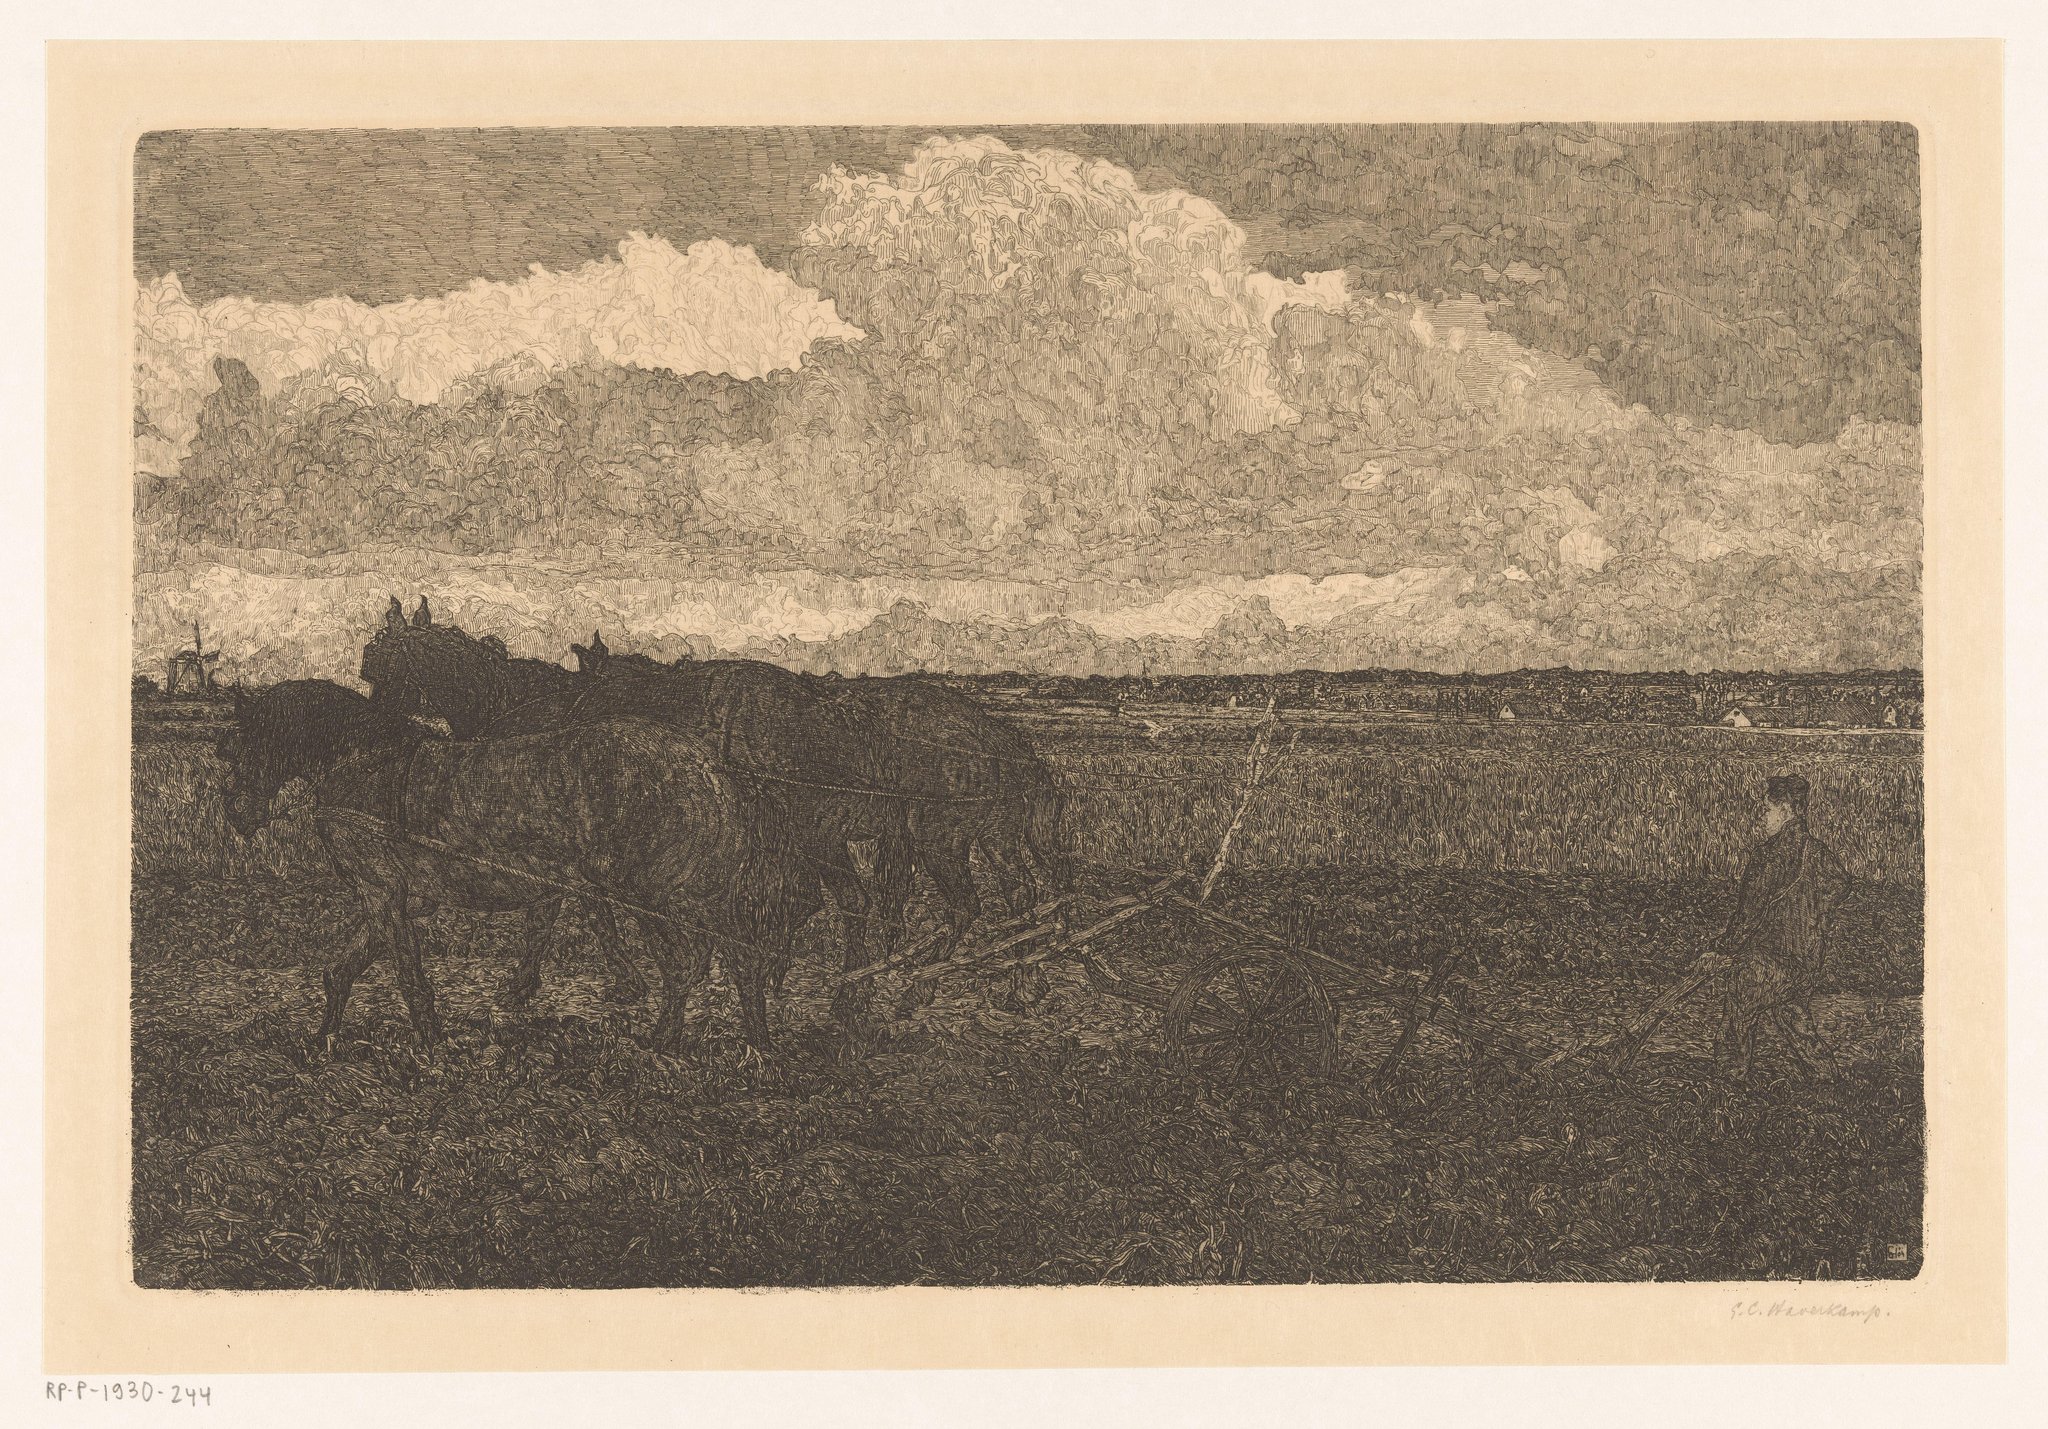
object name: print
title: Boer met drie ploegende paarden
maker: gerrit haverkamp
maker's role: print maker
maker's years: 1872-1926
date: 1904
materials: paper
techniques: etching, intaglio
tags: horse, ploughing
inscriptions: collector's mark: Lugt 2228